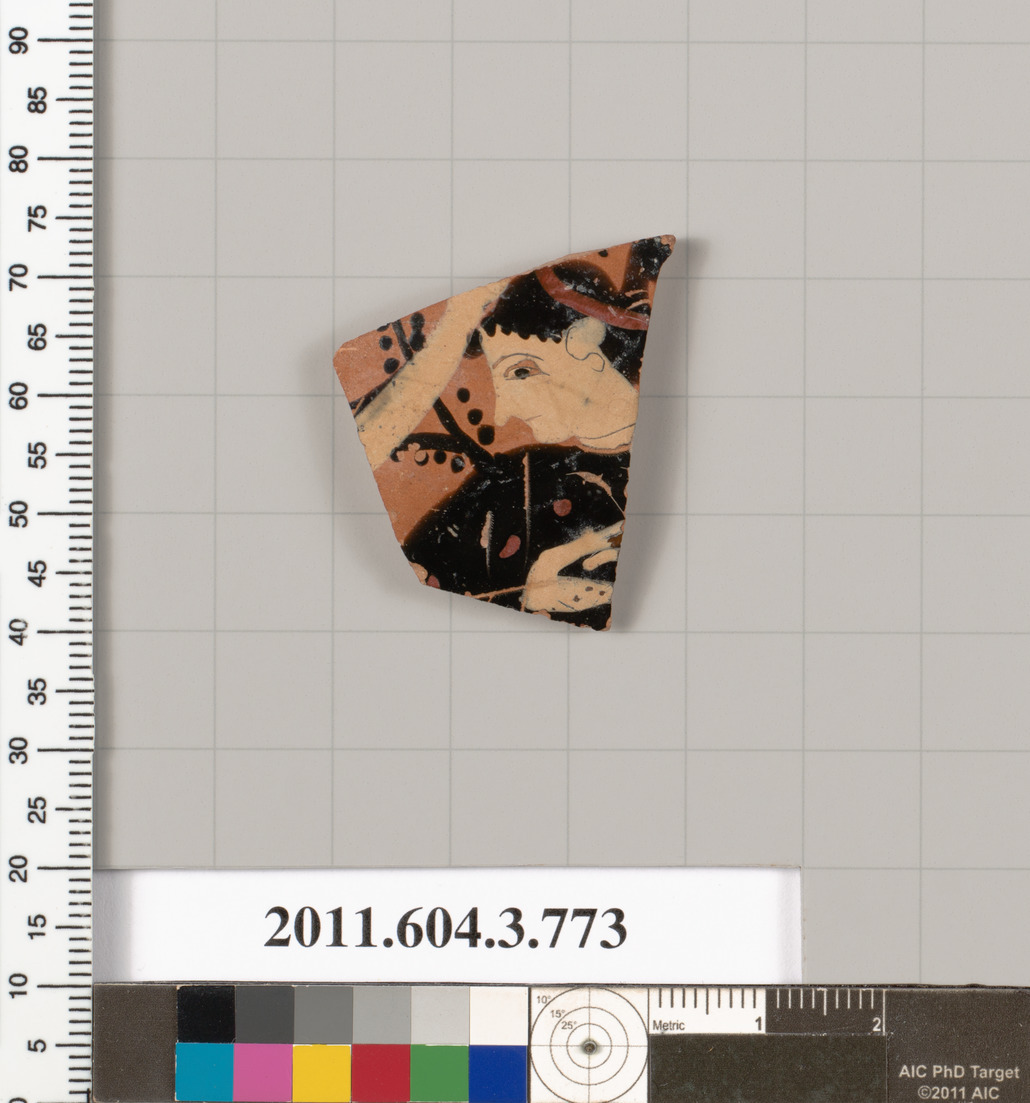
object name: oinochoe fragment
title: Terracotta fragment of an oinochoe (jug)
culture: greek, attic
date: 534-468 BCE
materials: terracotta